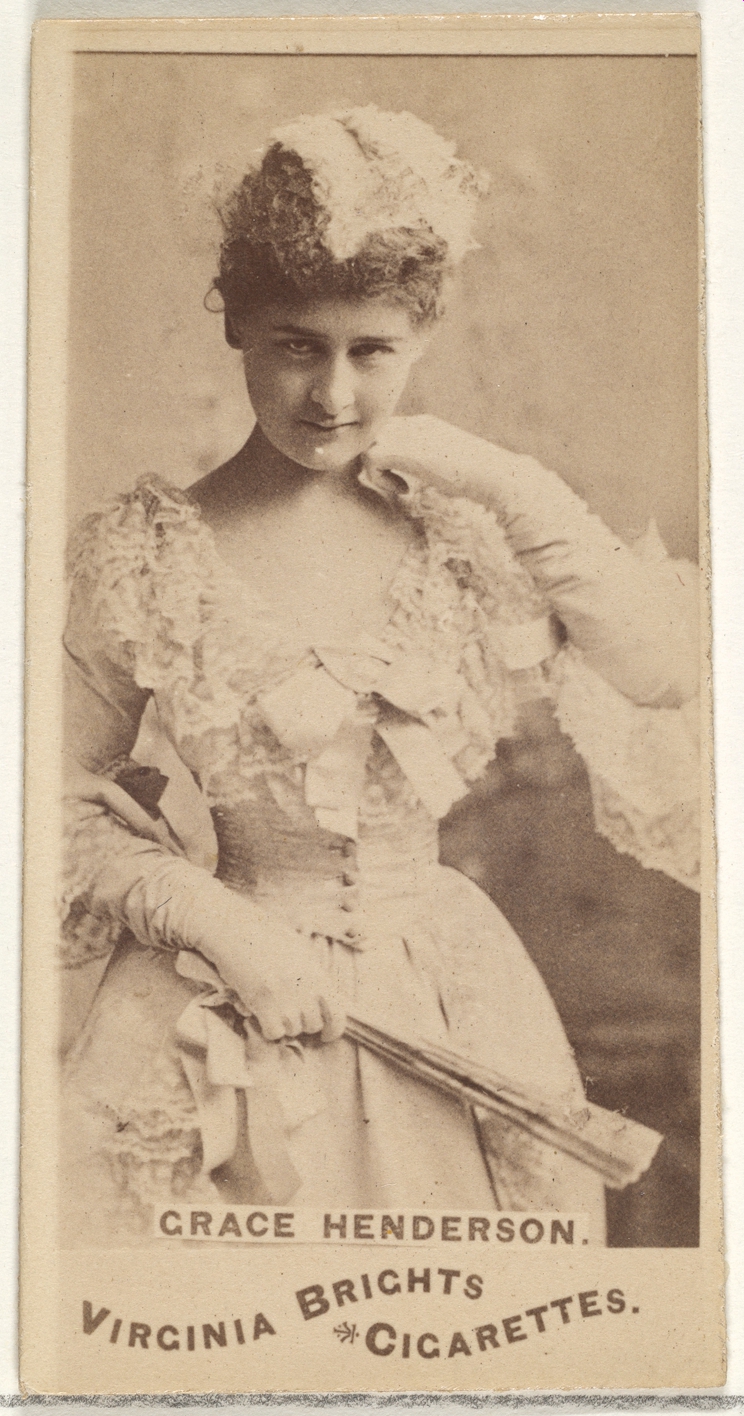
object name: photograph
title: Grace Henderson, from the Actors and Actresses series (N45, Type 1) for Virginia Brights Cigarettes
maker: allen & ginter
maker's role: publisher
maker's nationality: american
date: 1888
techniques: albumen silver print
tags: portraits,women,actresses